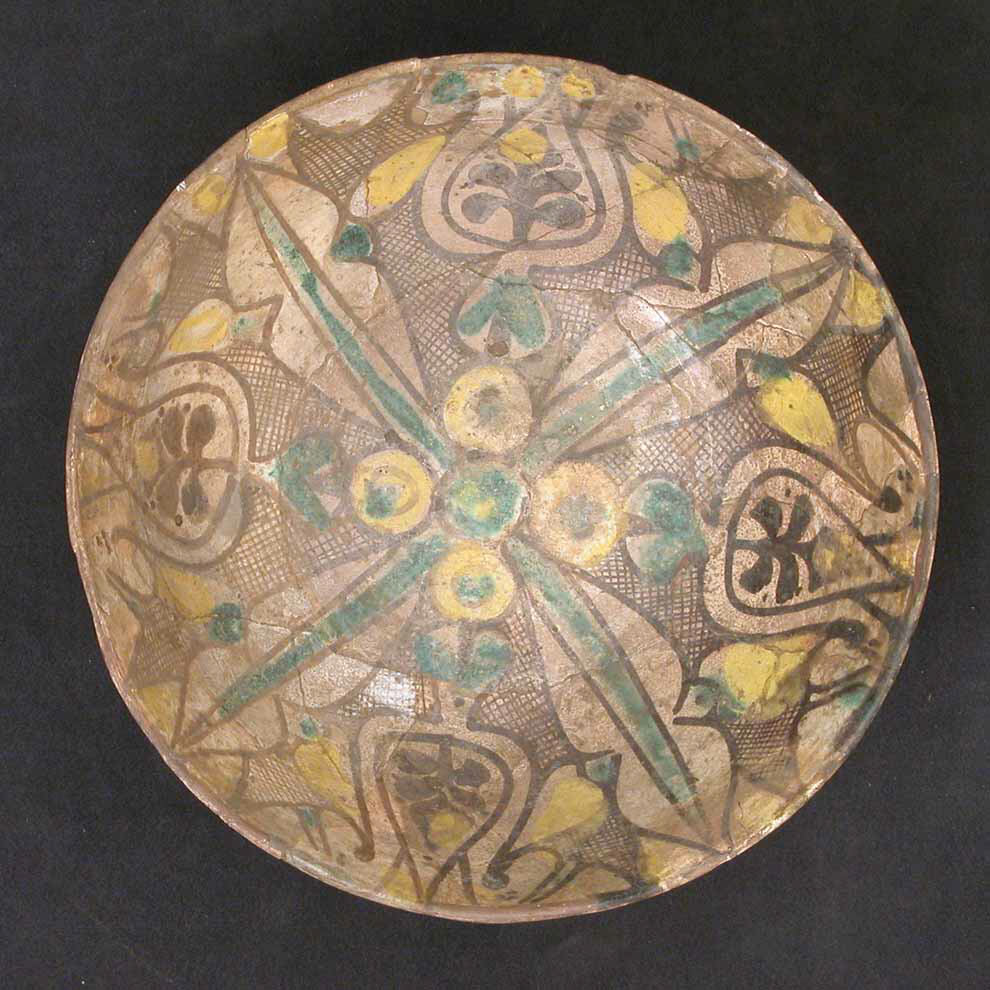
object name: bowl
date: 801-900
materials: earthenware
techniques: glazing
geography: iran